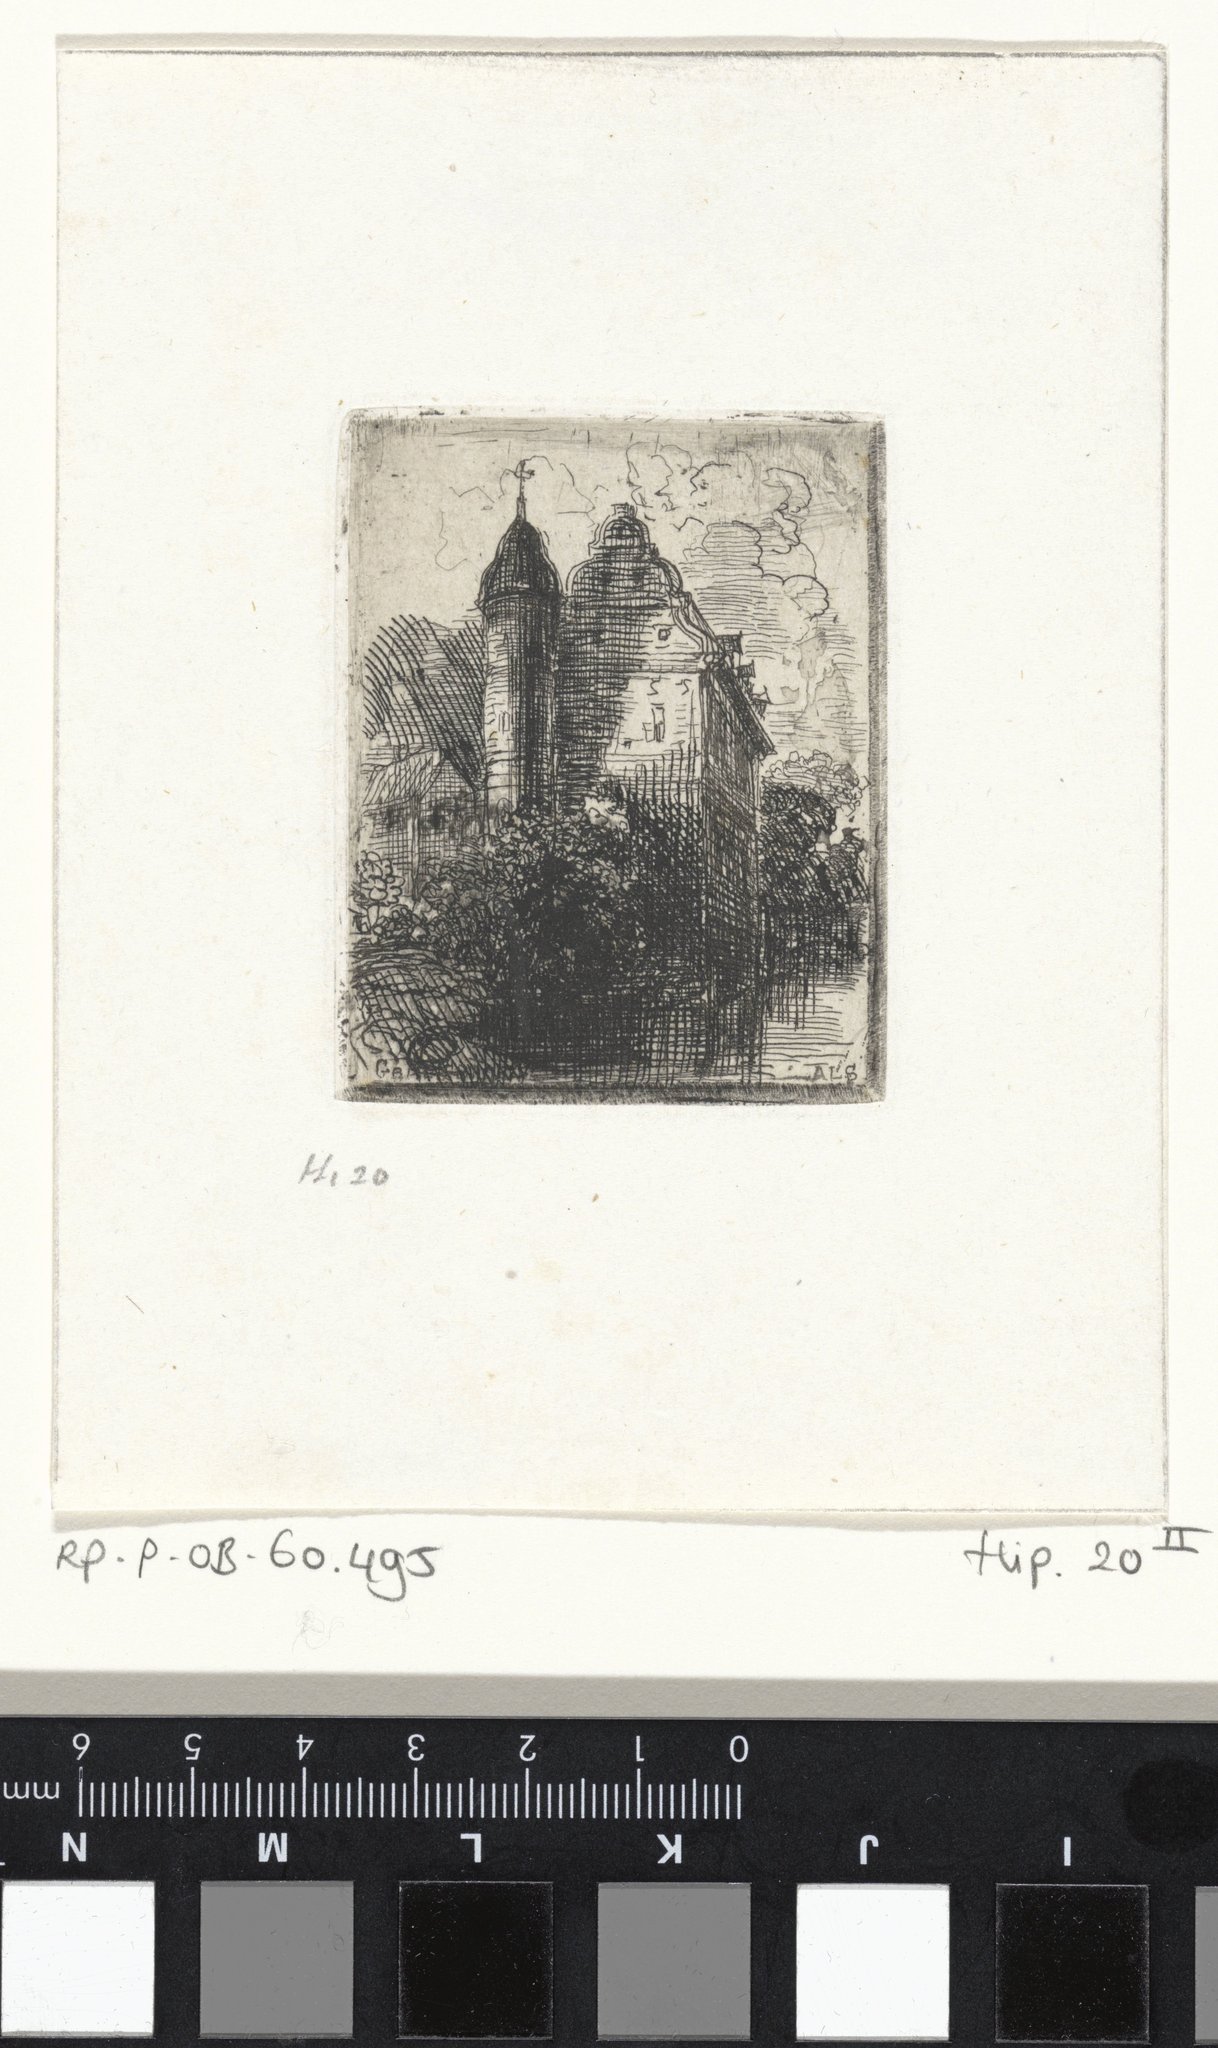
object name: print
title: Graesbroeck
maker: alexander schaepkens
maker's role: draughtsman, print maker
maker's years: 1815-1899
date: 1830-1899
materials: paper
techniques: etching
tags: castle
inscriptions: collector's mark: Lugt 2228